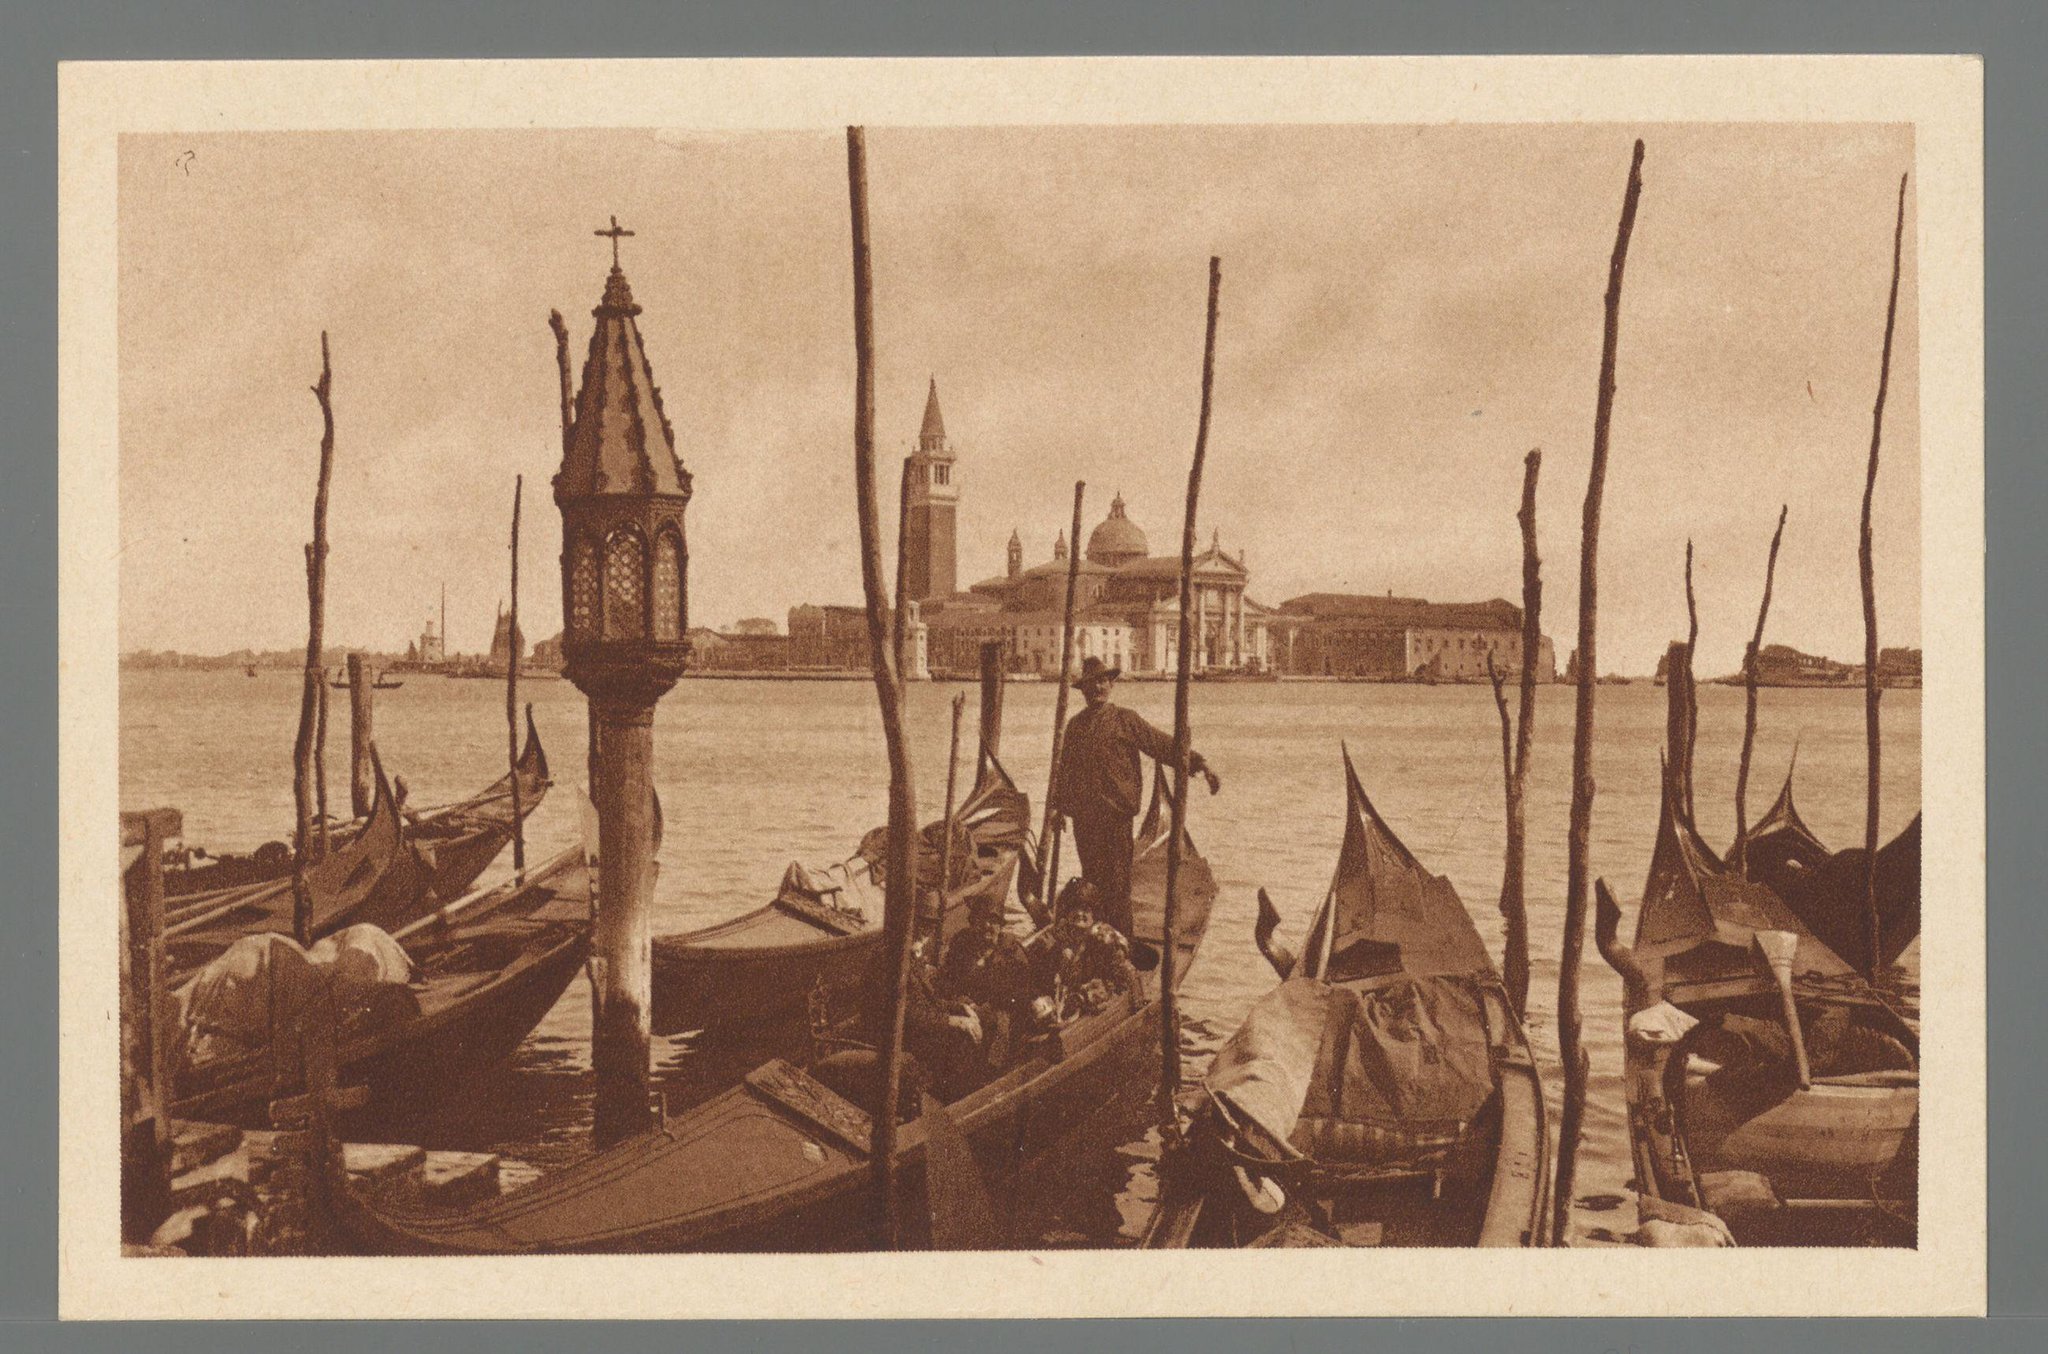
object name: photomechanical print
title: Venezia. Traghetto S. Marco e Isola S. Giorgio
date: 1906-1930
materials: cardboard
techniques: rotogravure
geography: venice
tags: church (exterior), gondola, sea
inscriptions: collector's mark: ‘AFE v S’